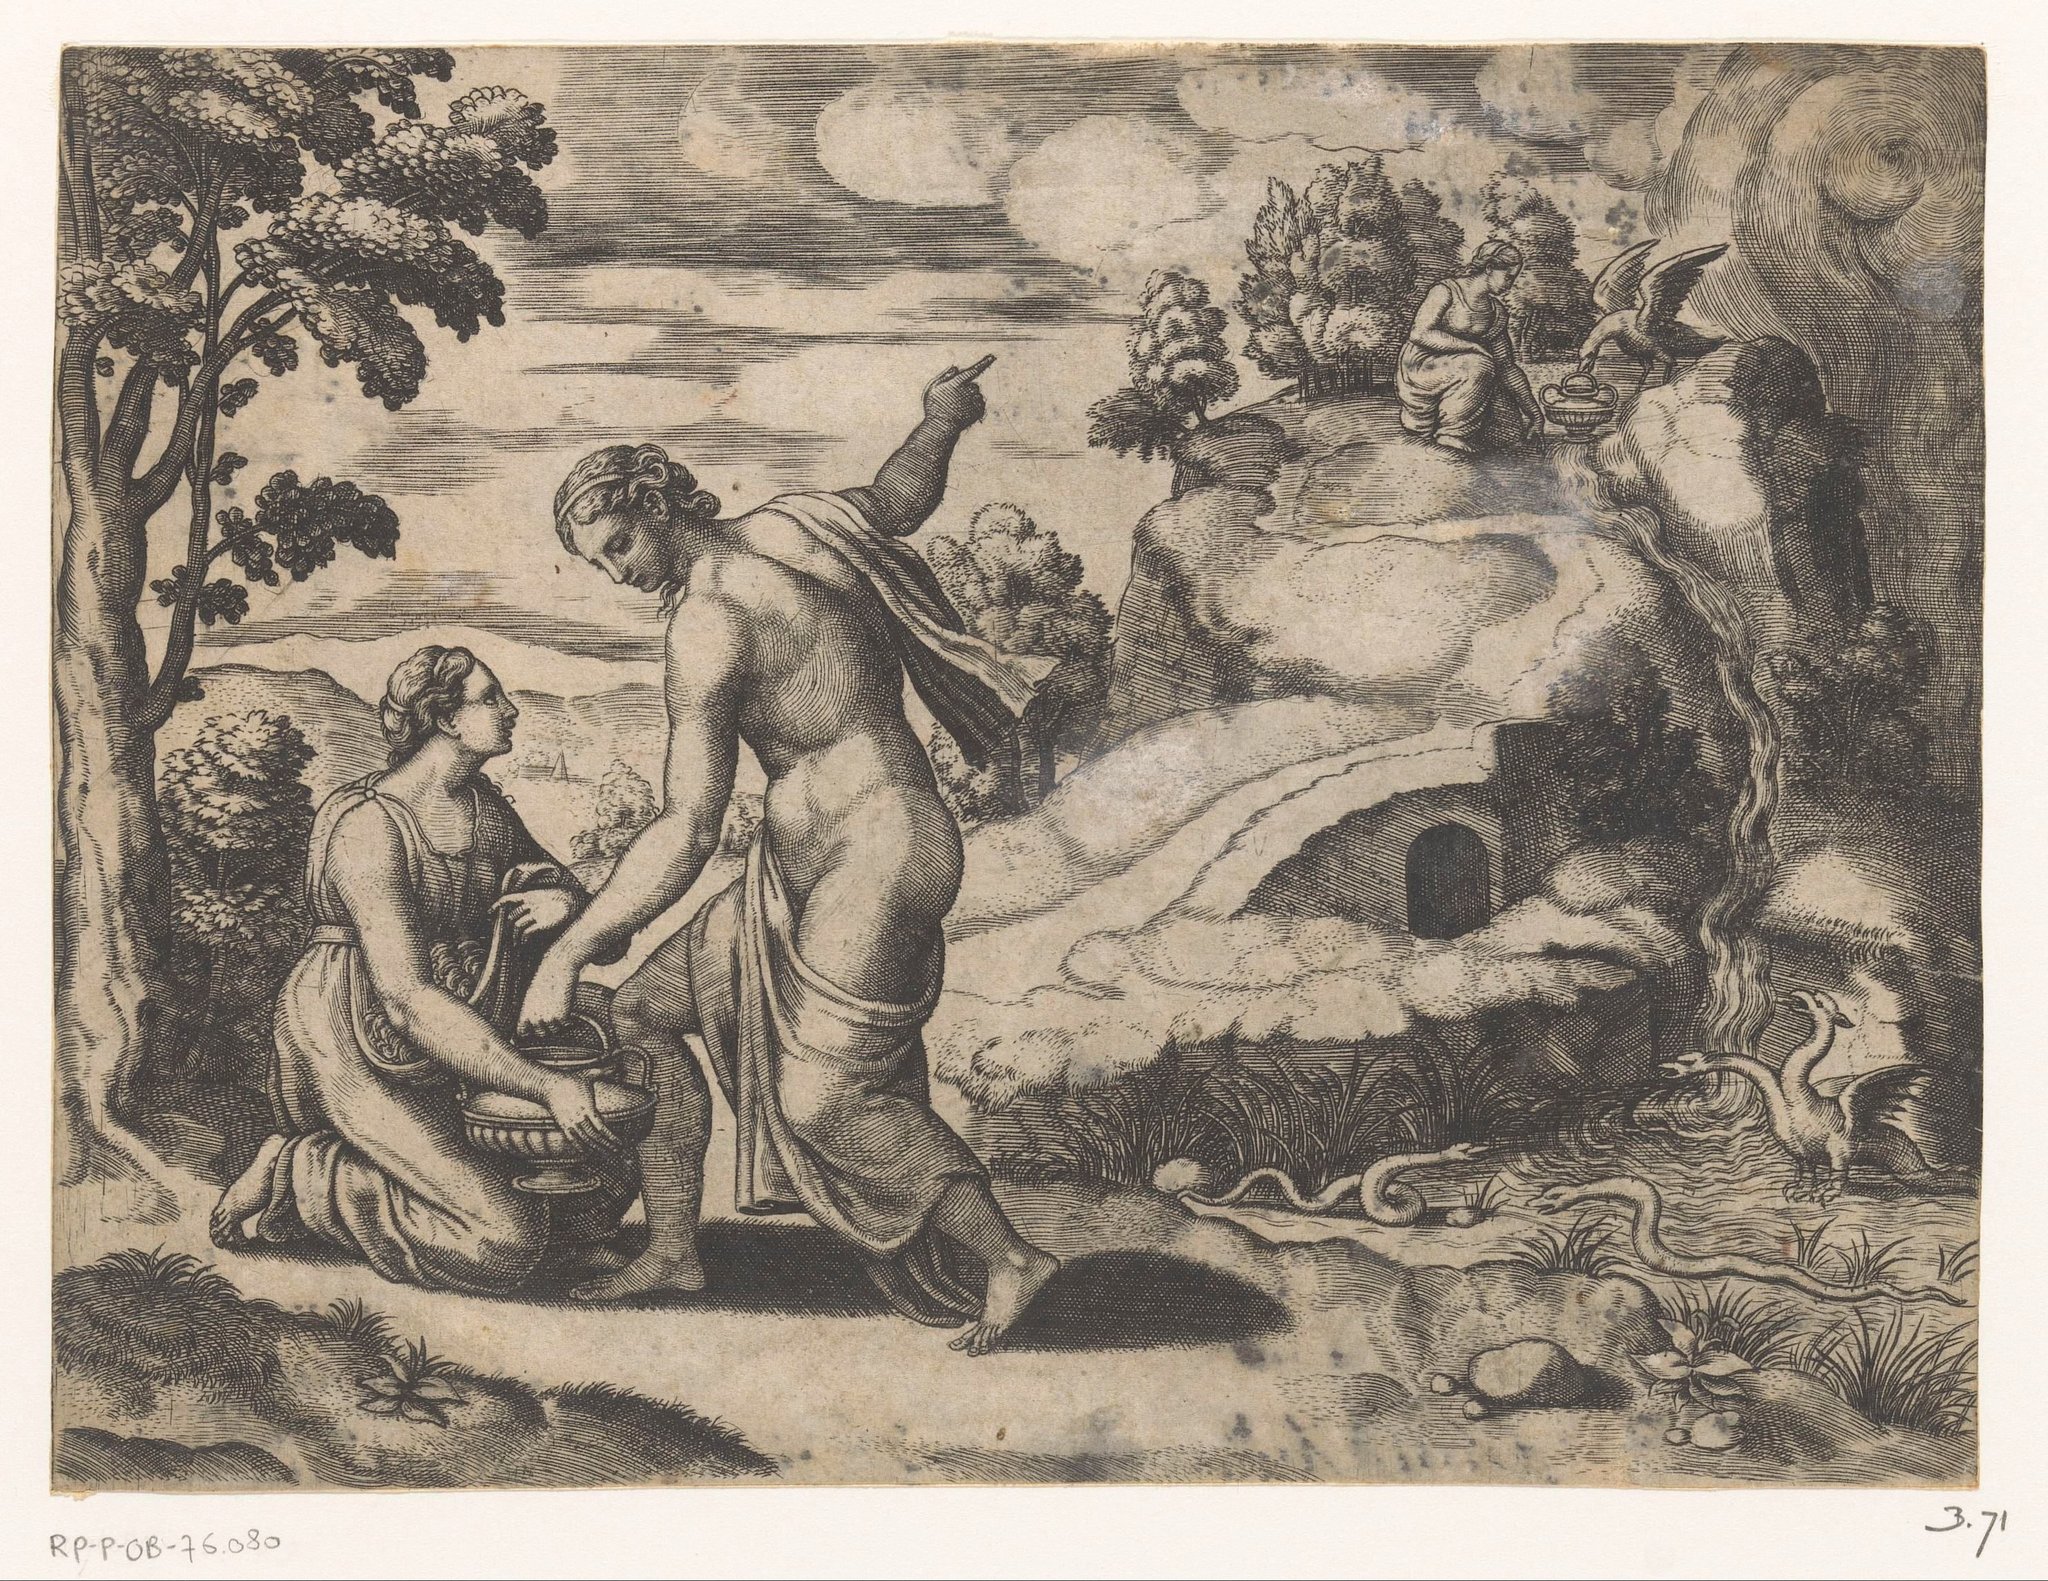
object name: print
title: Venus stuurt Psyche naar een bron bewaakt door draken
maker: meester van de dobbelsteen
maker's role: print maker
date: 1530-1560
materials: paper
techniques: engraving, intaglio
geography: italy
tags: the eagle of jupiter fetches water from the styx with psyche's jar, psyche performing various tasks set to her by venus, styx (river of hades); 'stige' (ripa)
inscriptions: collector's mark: Lugt 240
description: Venus draagt Psyche de taak op om water te halen uit een bron die bewaakt wordt door draken. Rechts op een berg de adelaar van Jupiter die Psyche water brengt uit de Styx.